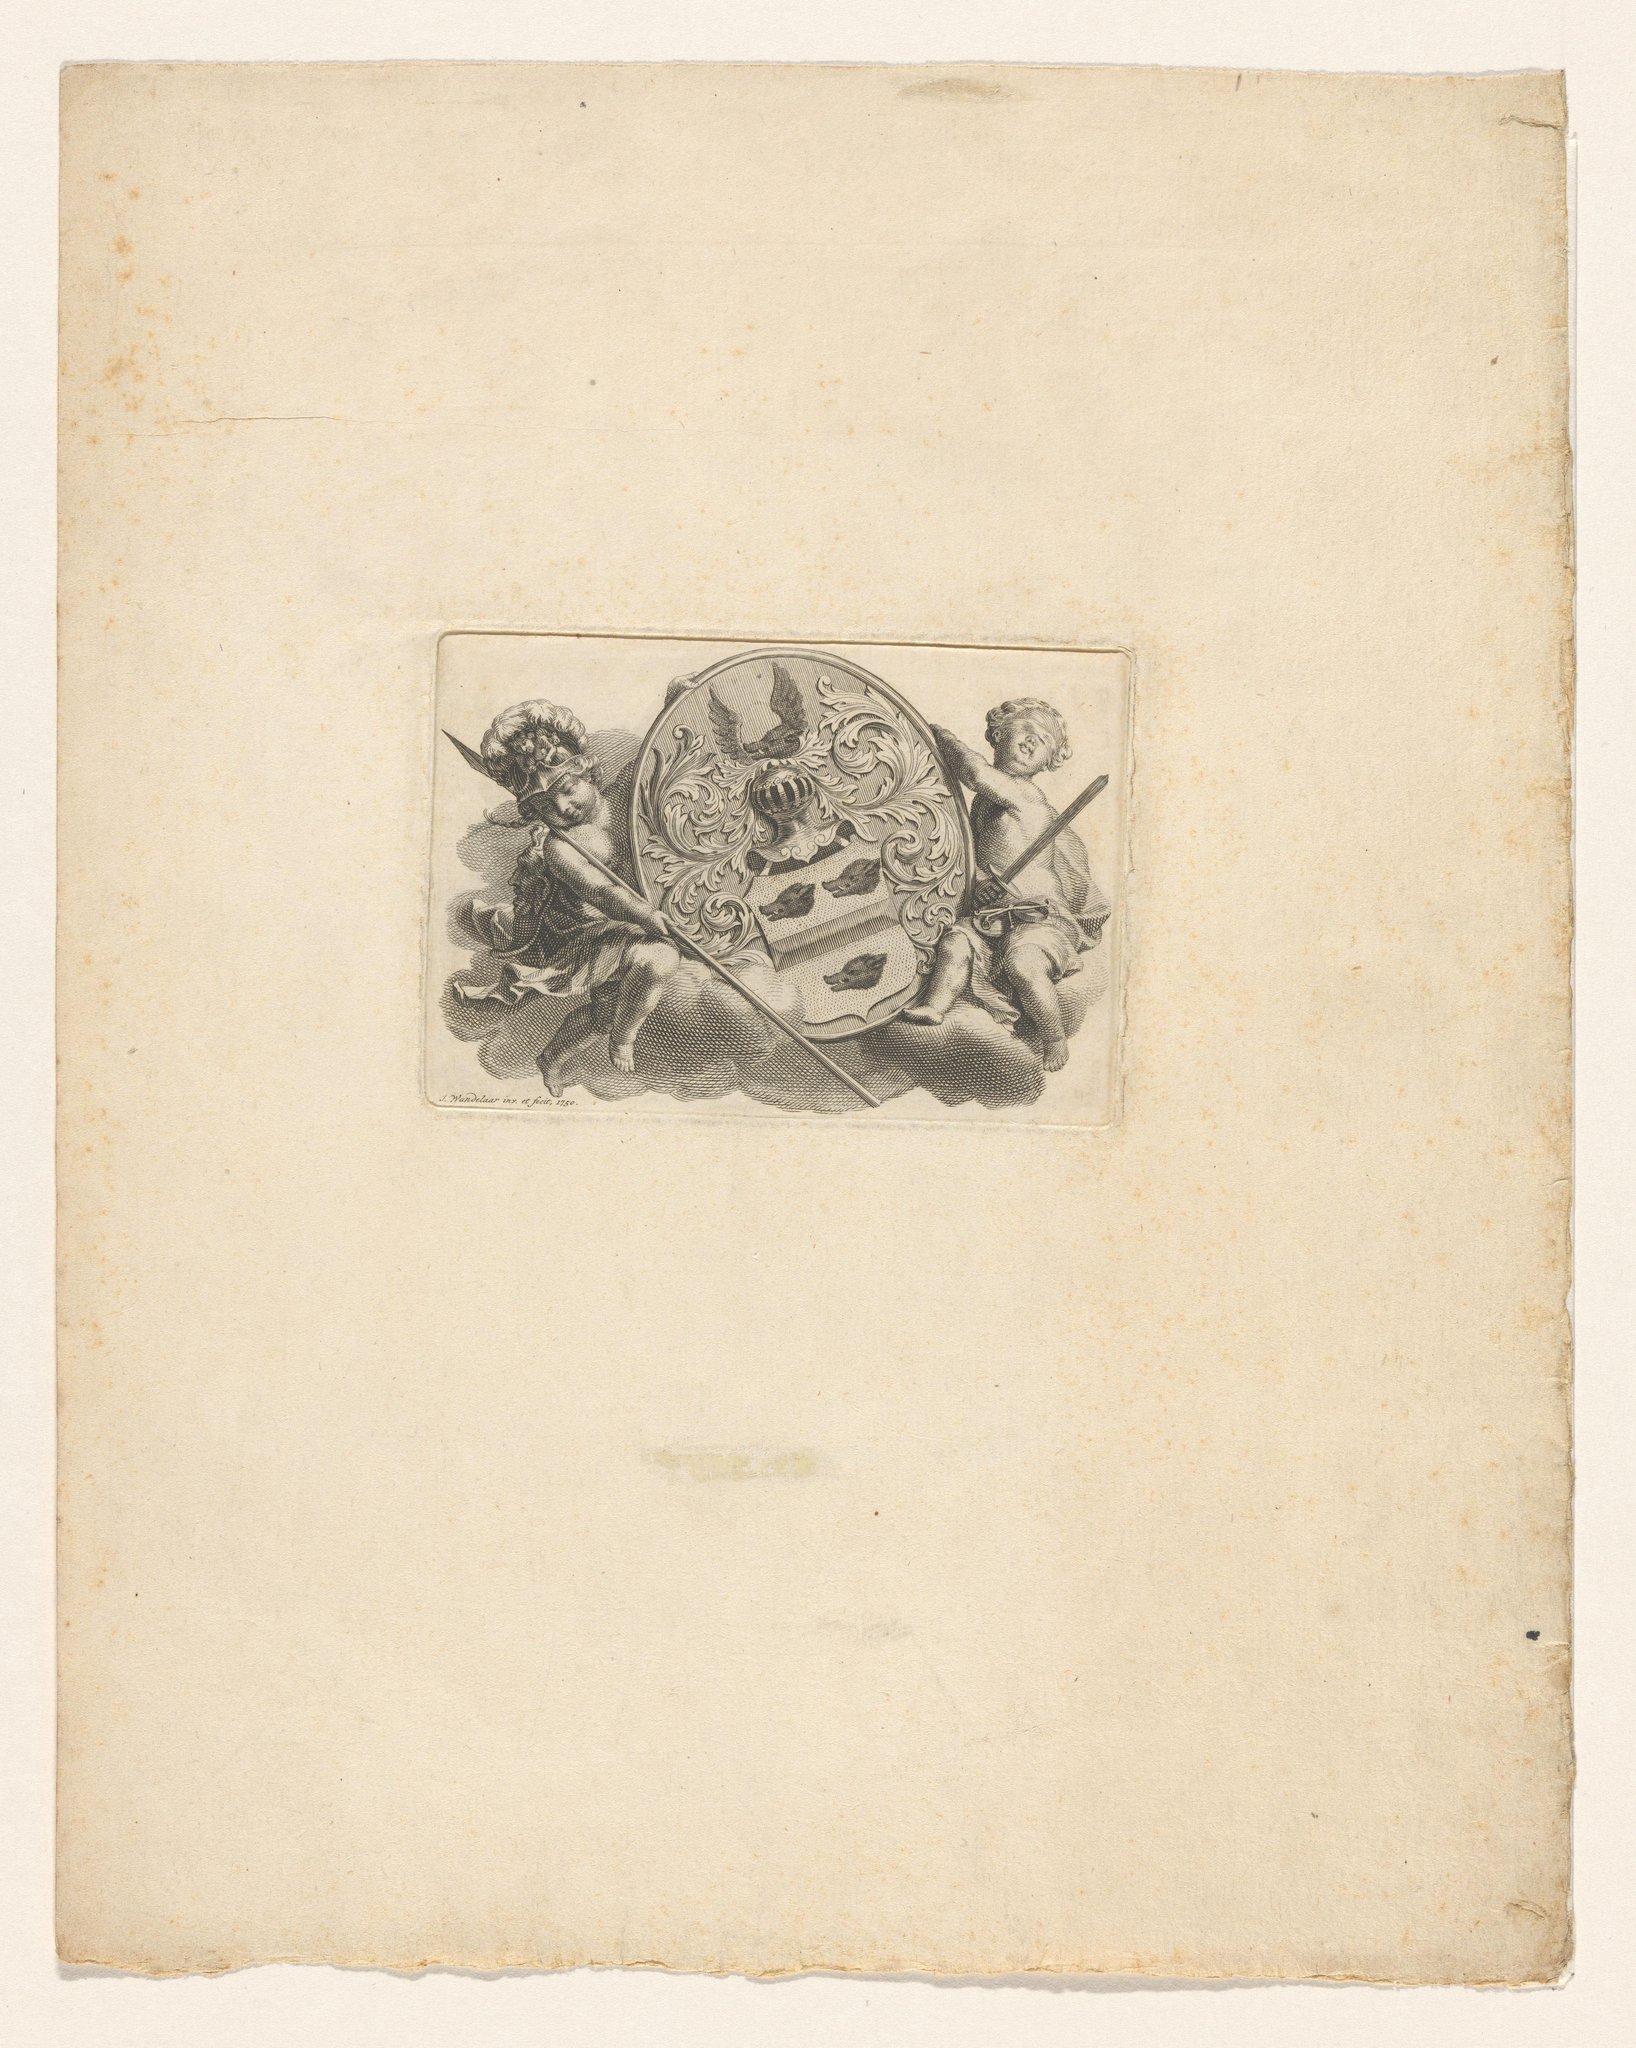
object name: print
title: Putti aan weerszijden van een familiewapen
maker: jan wandelaar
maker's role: draughtsman, print maker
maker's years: 1690-1759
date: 1750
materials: paper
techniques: engraving, etching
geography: netherlands